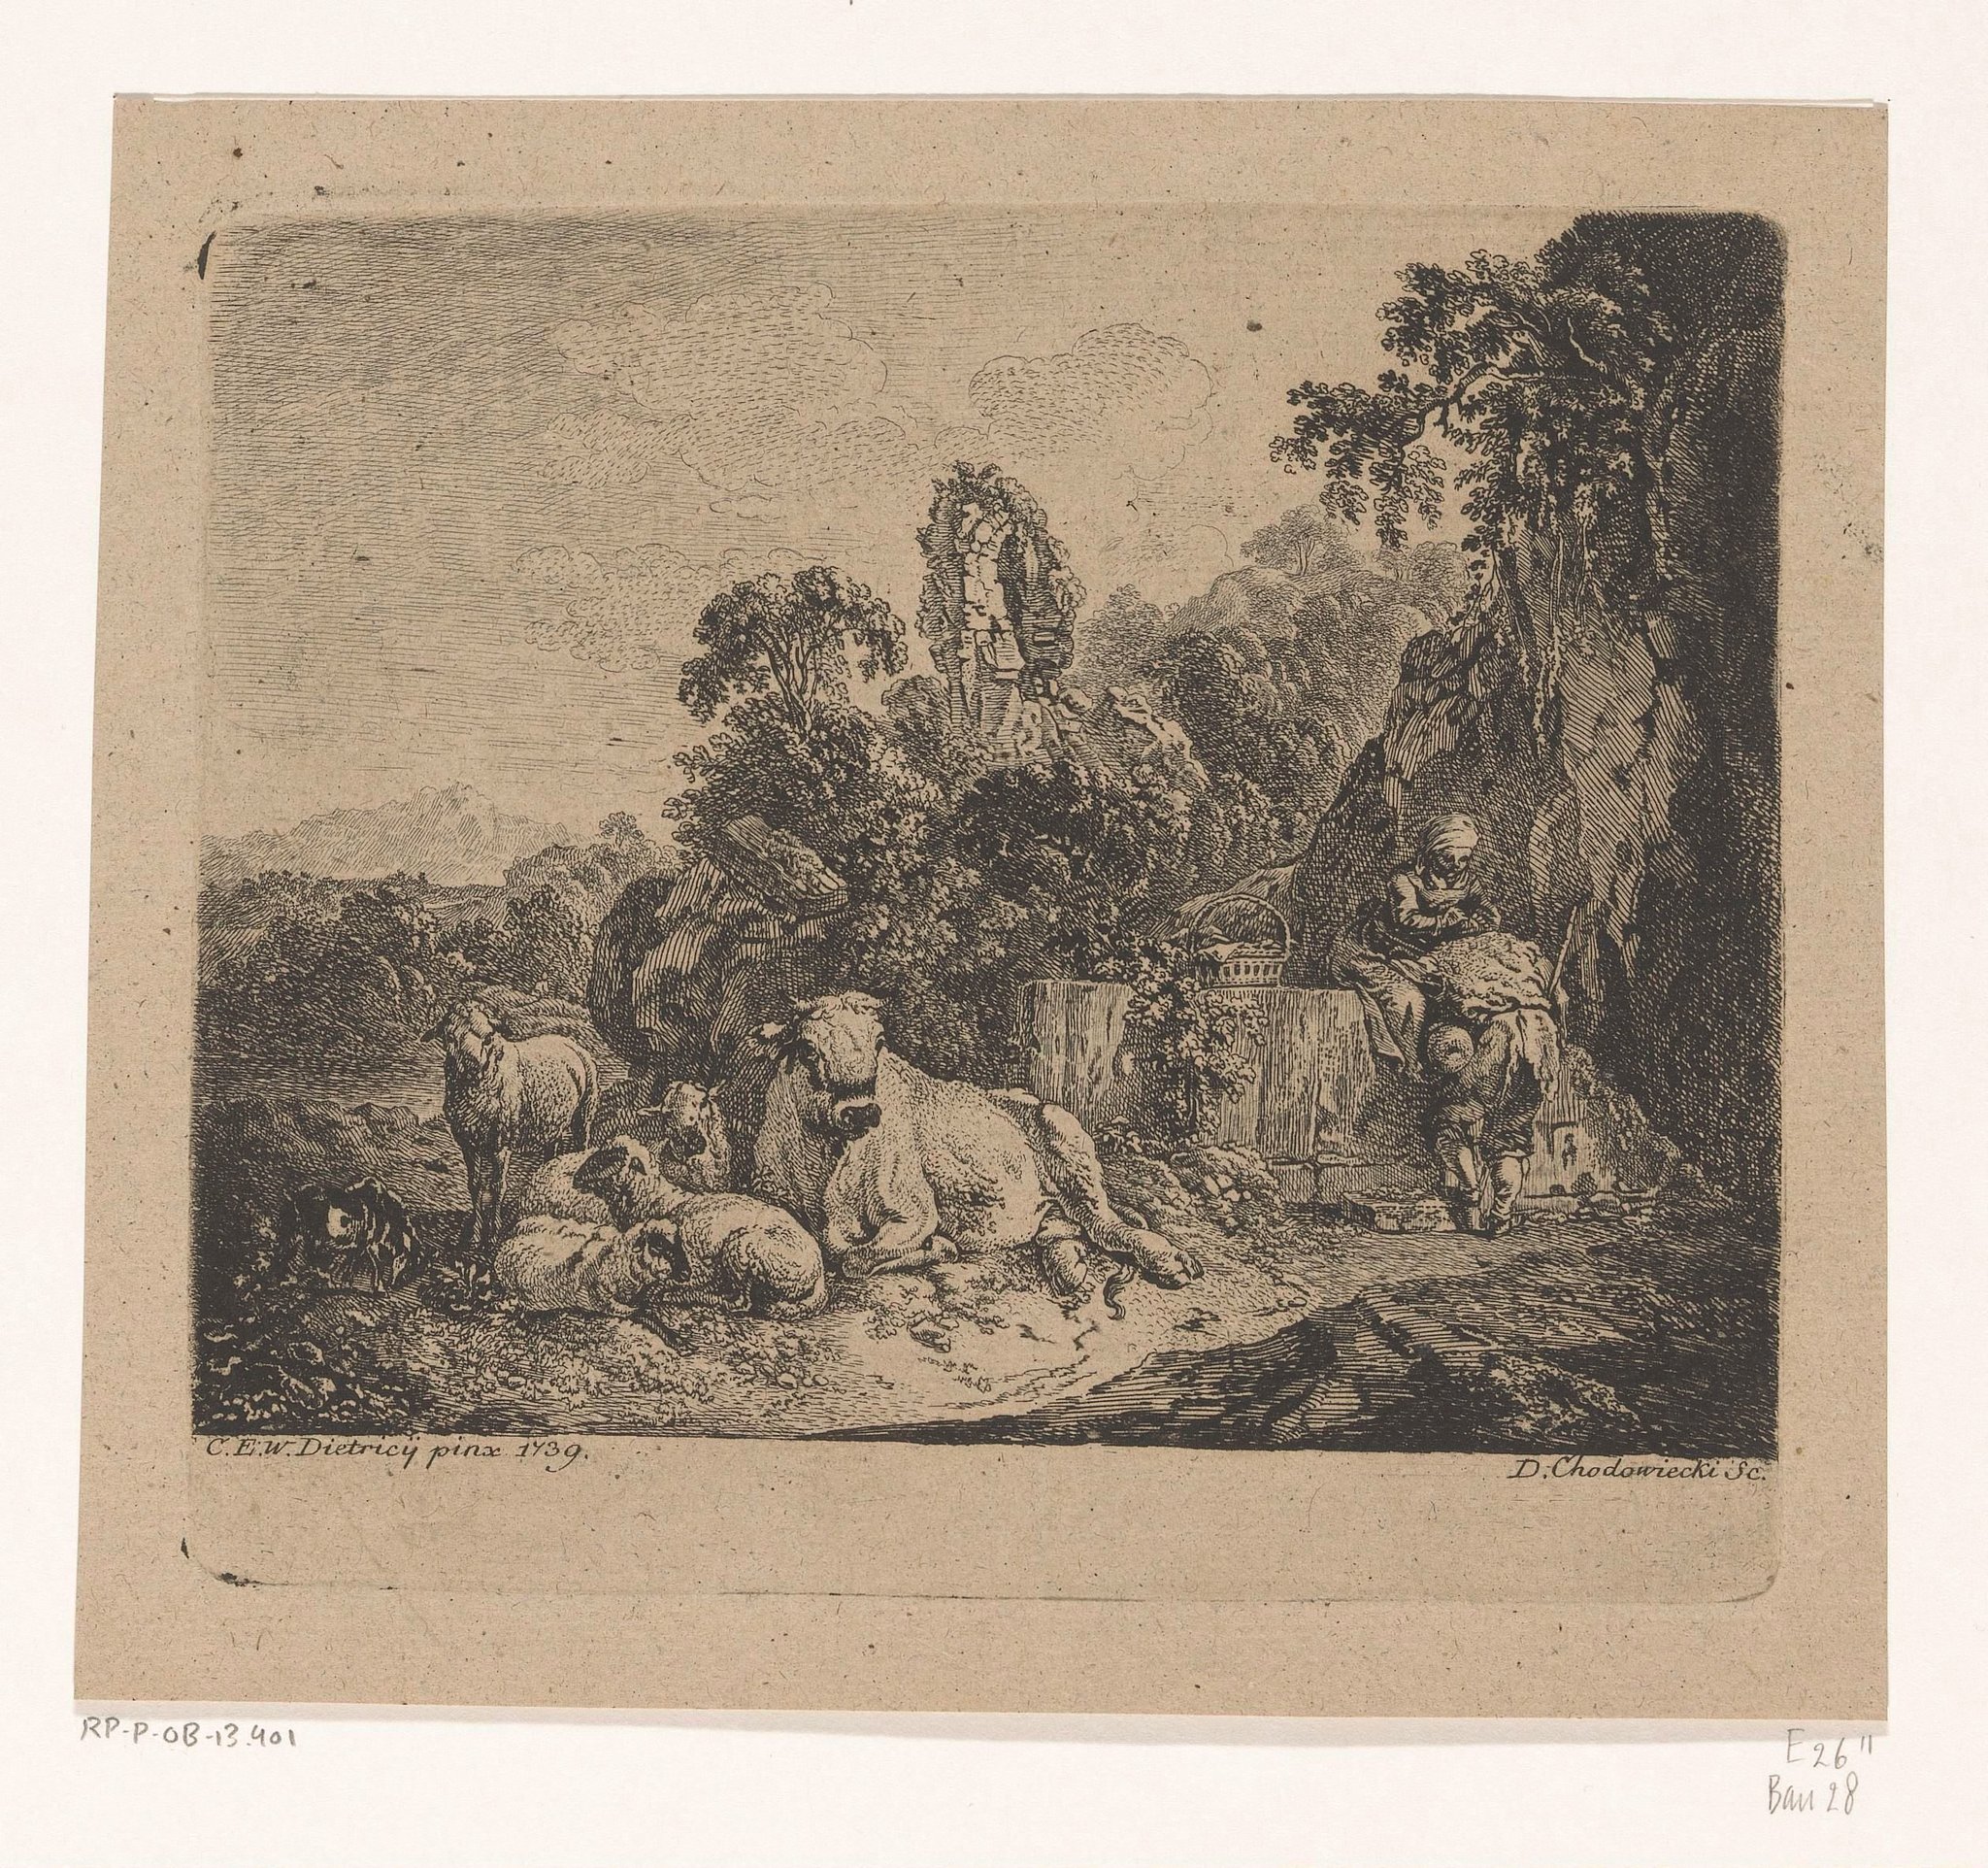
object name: print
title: Herder en herderin met vee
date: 1764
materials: paper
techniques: etching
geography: berlin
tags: cow, herding, herdsman, herdswoman, shepherd, shepherdess, cowherd, etc.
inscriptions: collector's mark: Lugt 2228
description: Prent in de stijl van Johann Heinrich Roos (1631-1685).